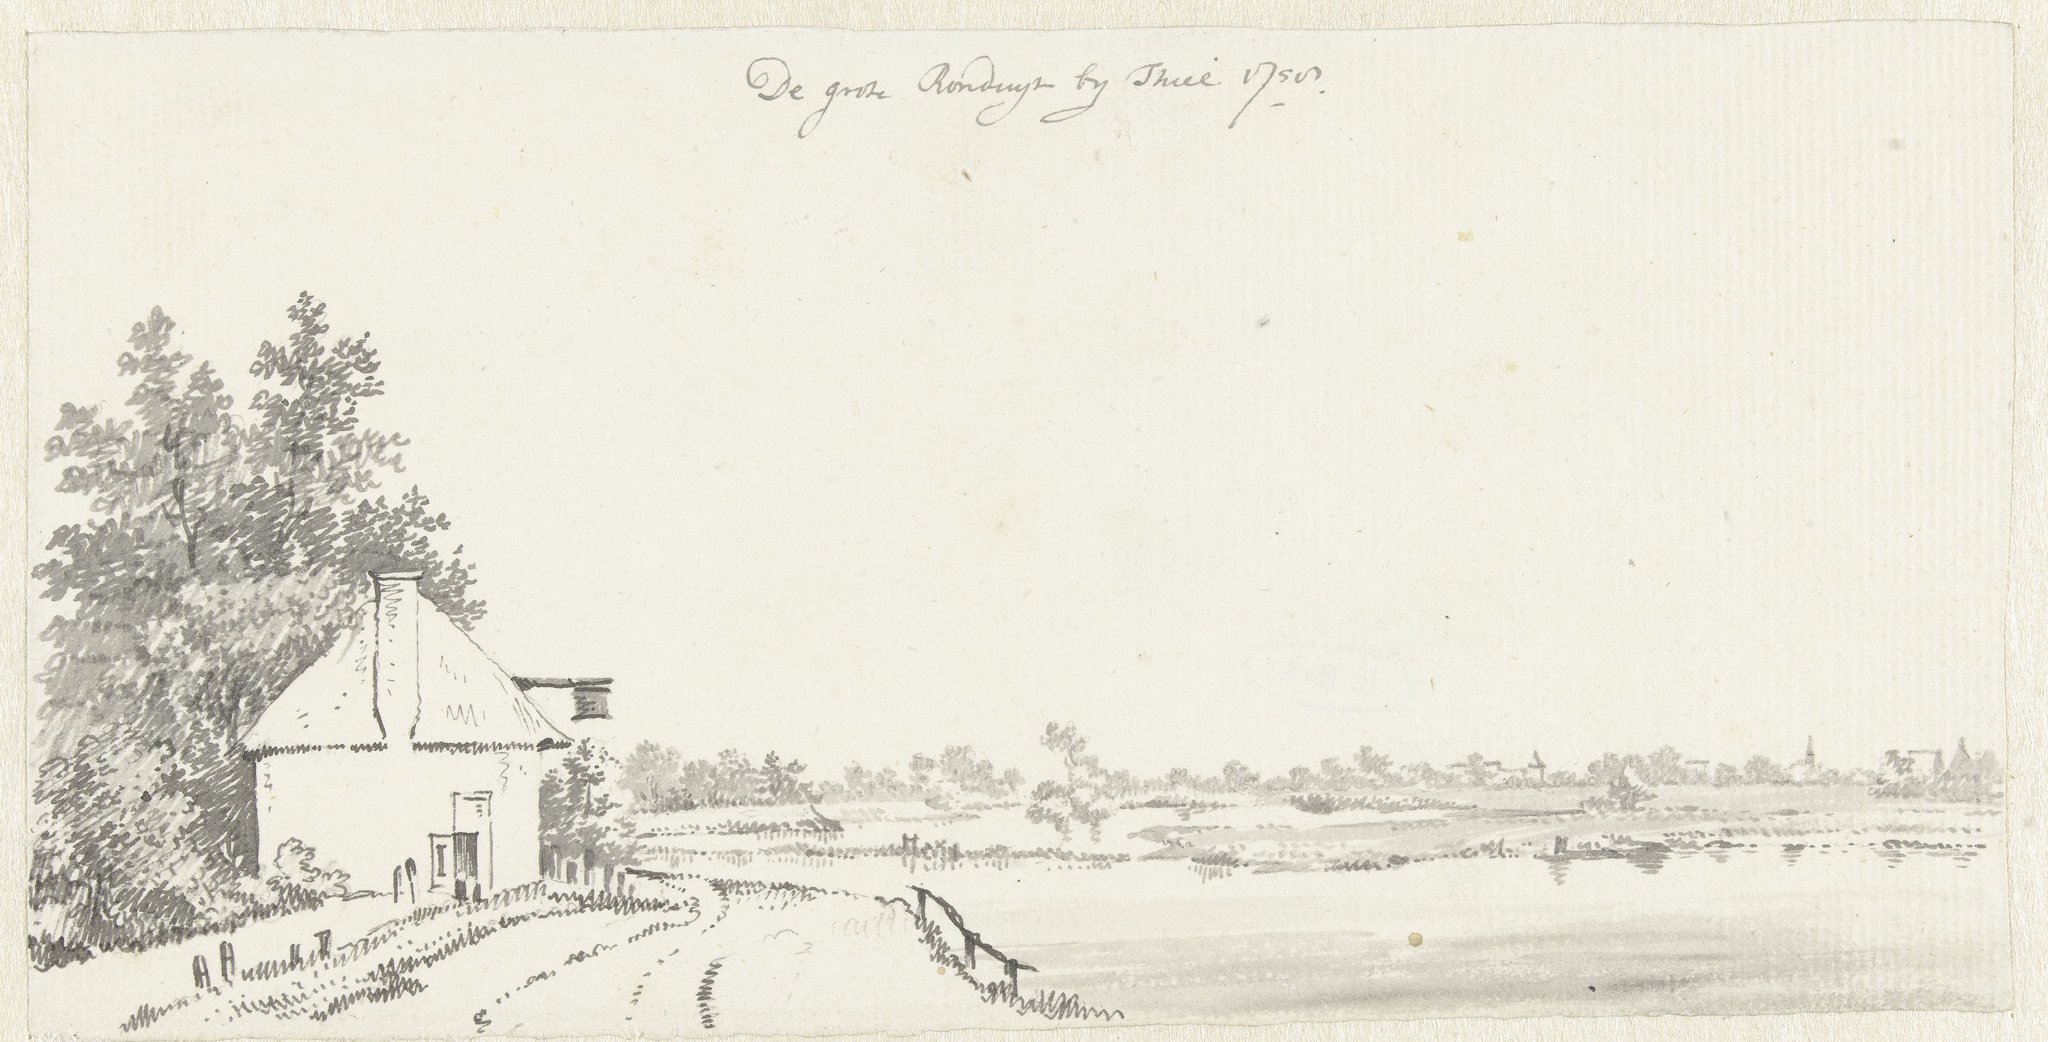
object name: drawing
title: De grote Ronduyt bij Tiel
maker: jan de beijer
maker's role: draughtsman, print maker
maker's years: 1703-1780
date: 1758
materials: ink, paper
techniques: brush, pen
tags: river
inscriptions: : ‘grote Ronduyt’